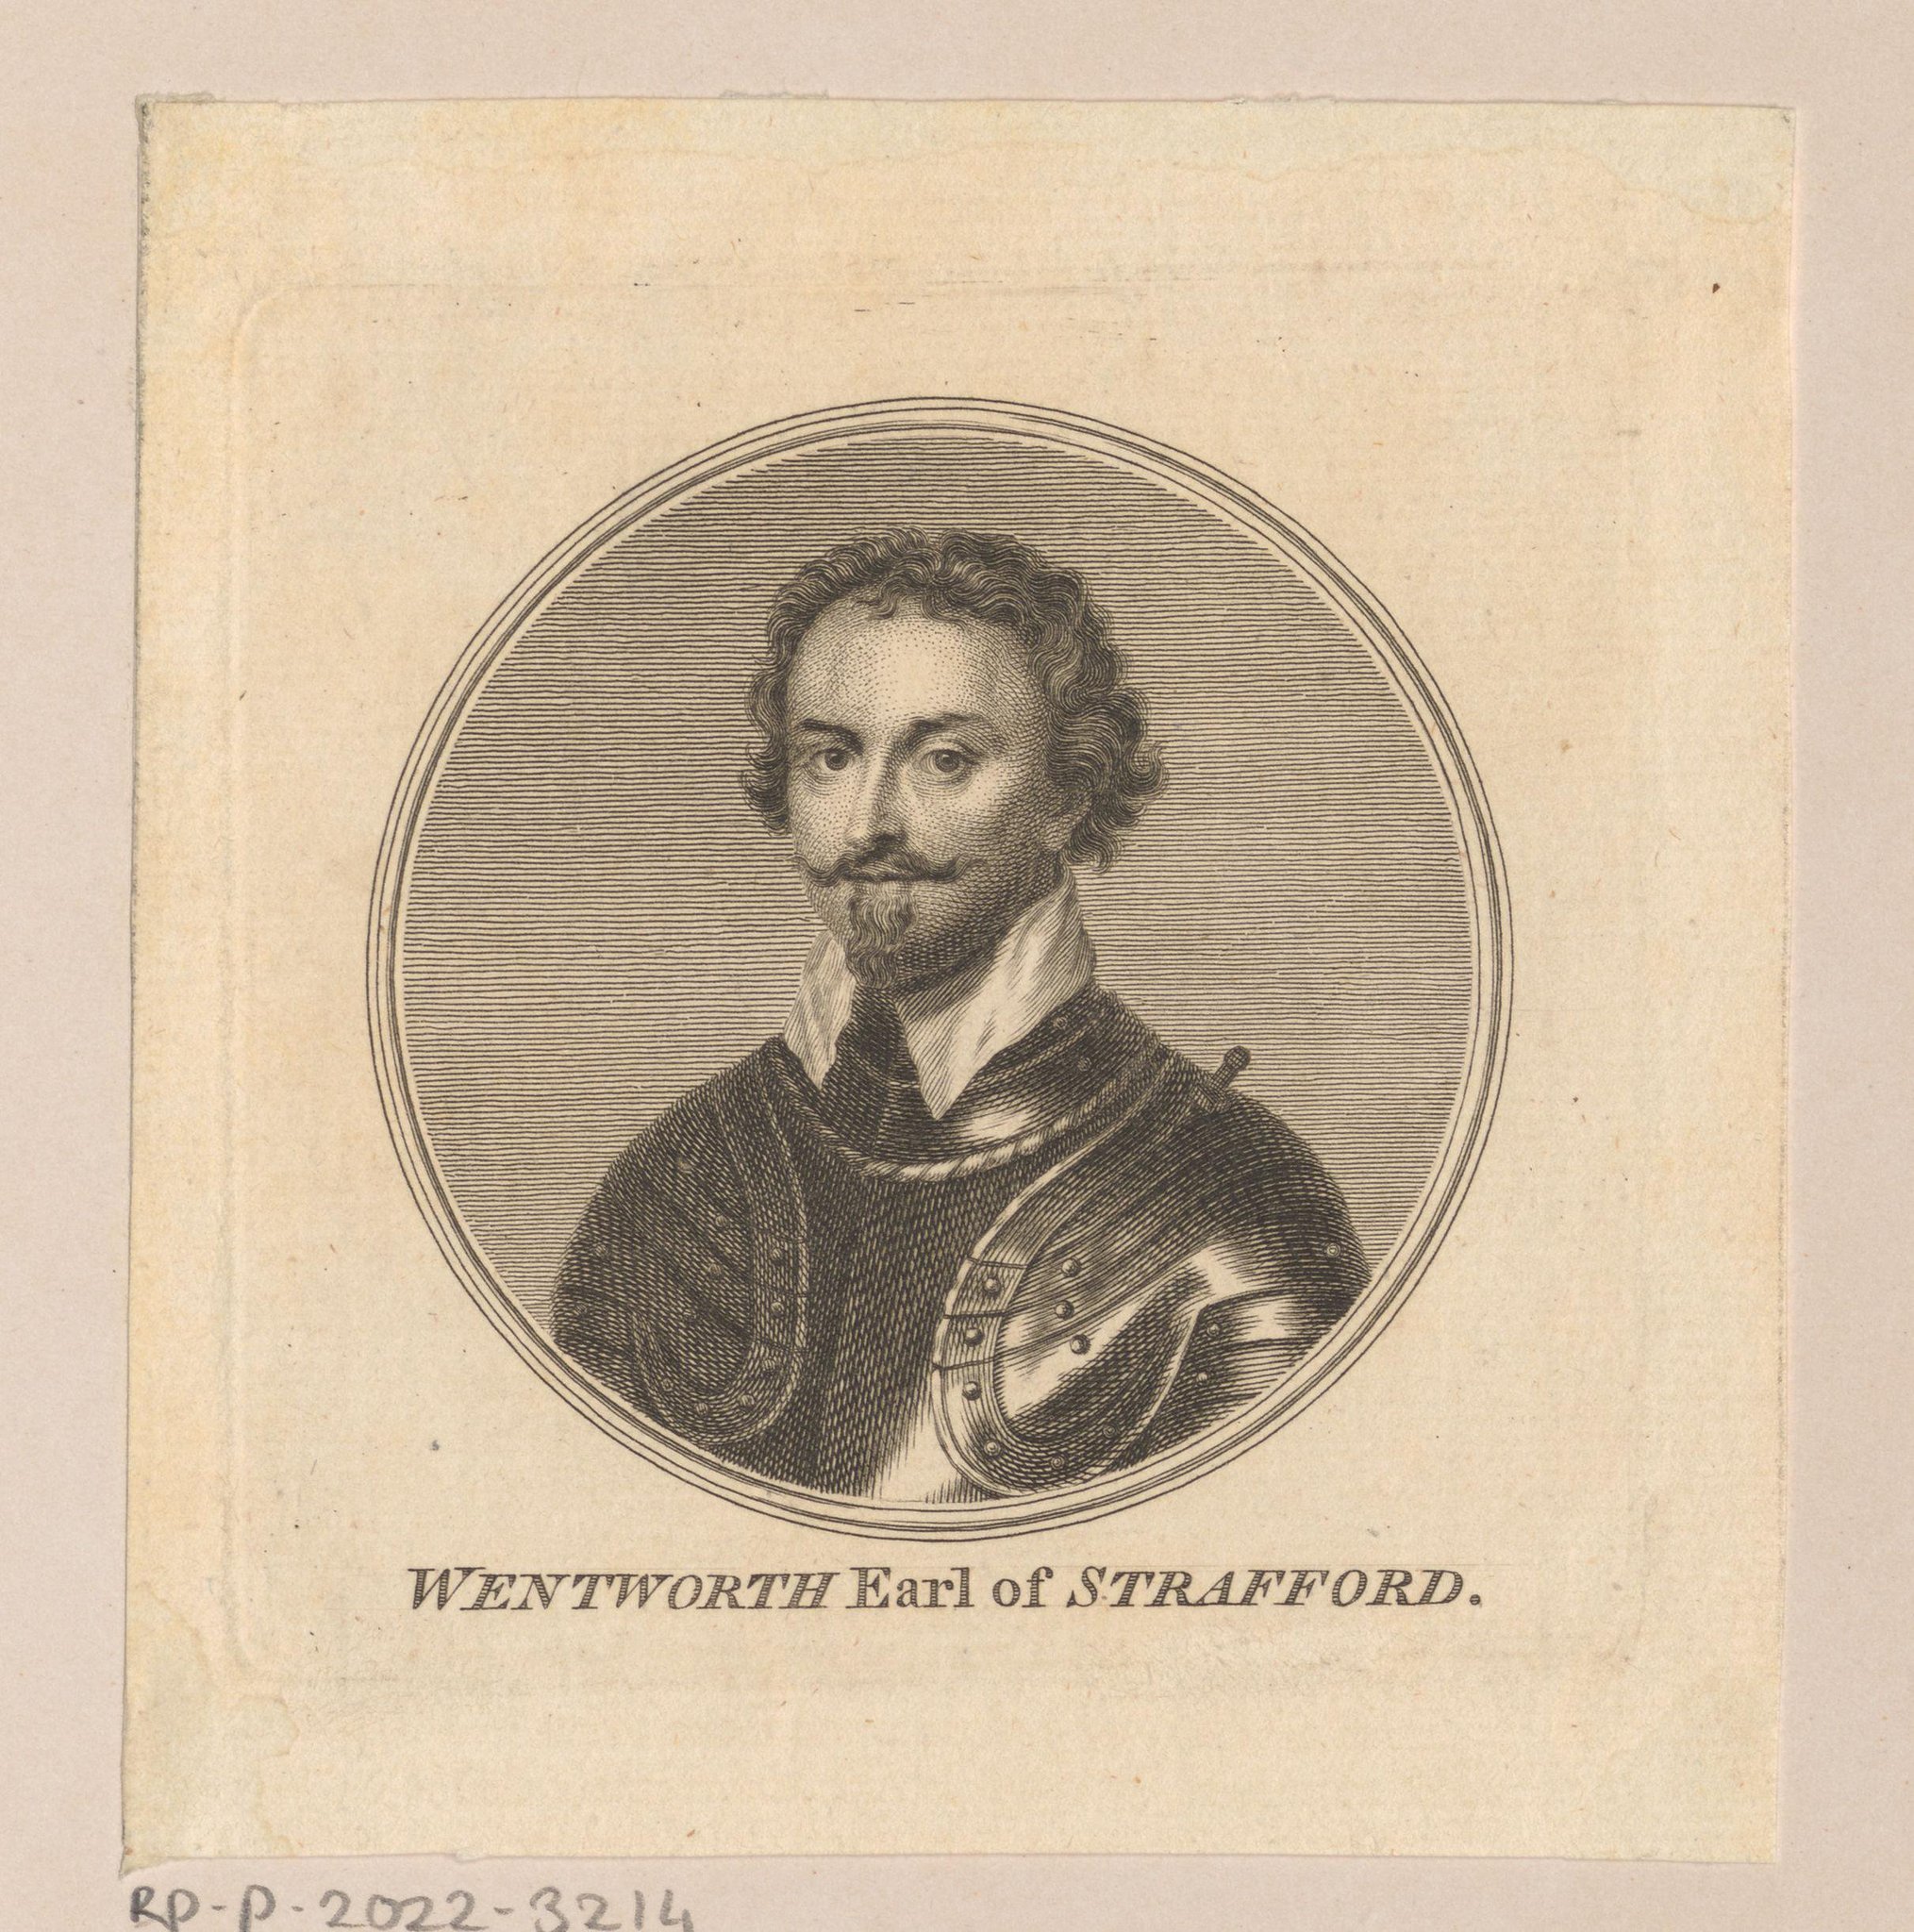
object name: print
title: Portret van Thomas Wentworth, eerste graaf van Strafford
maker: Anonymous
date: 1820-1899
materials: paper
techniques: engraving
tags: london, historical persons, other sovereign (with title), politician, e.g. party leader